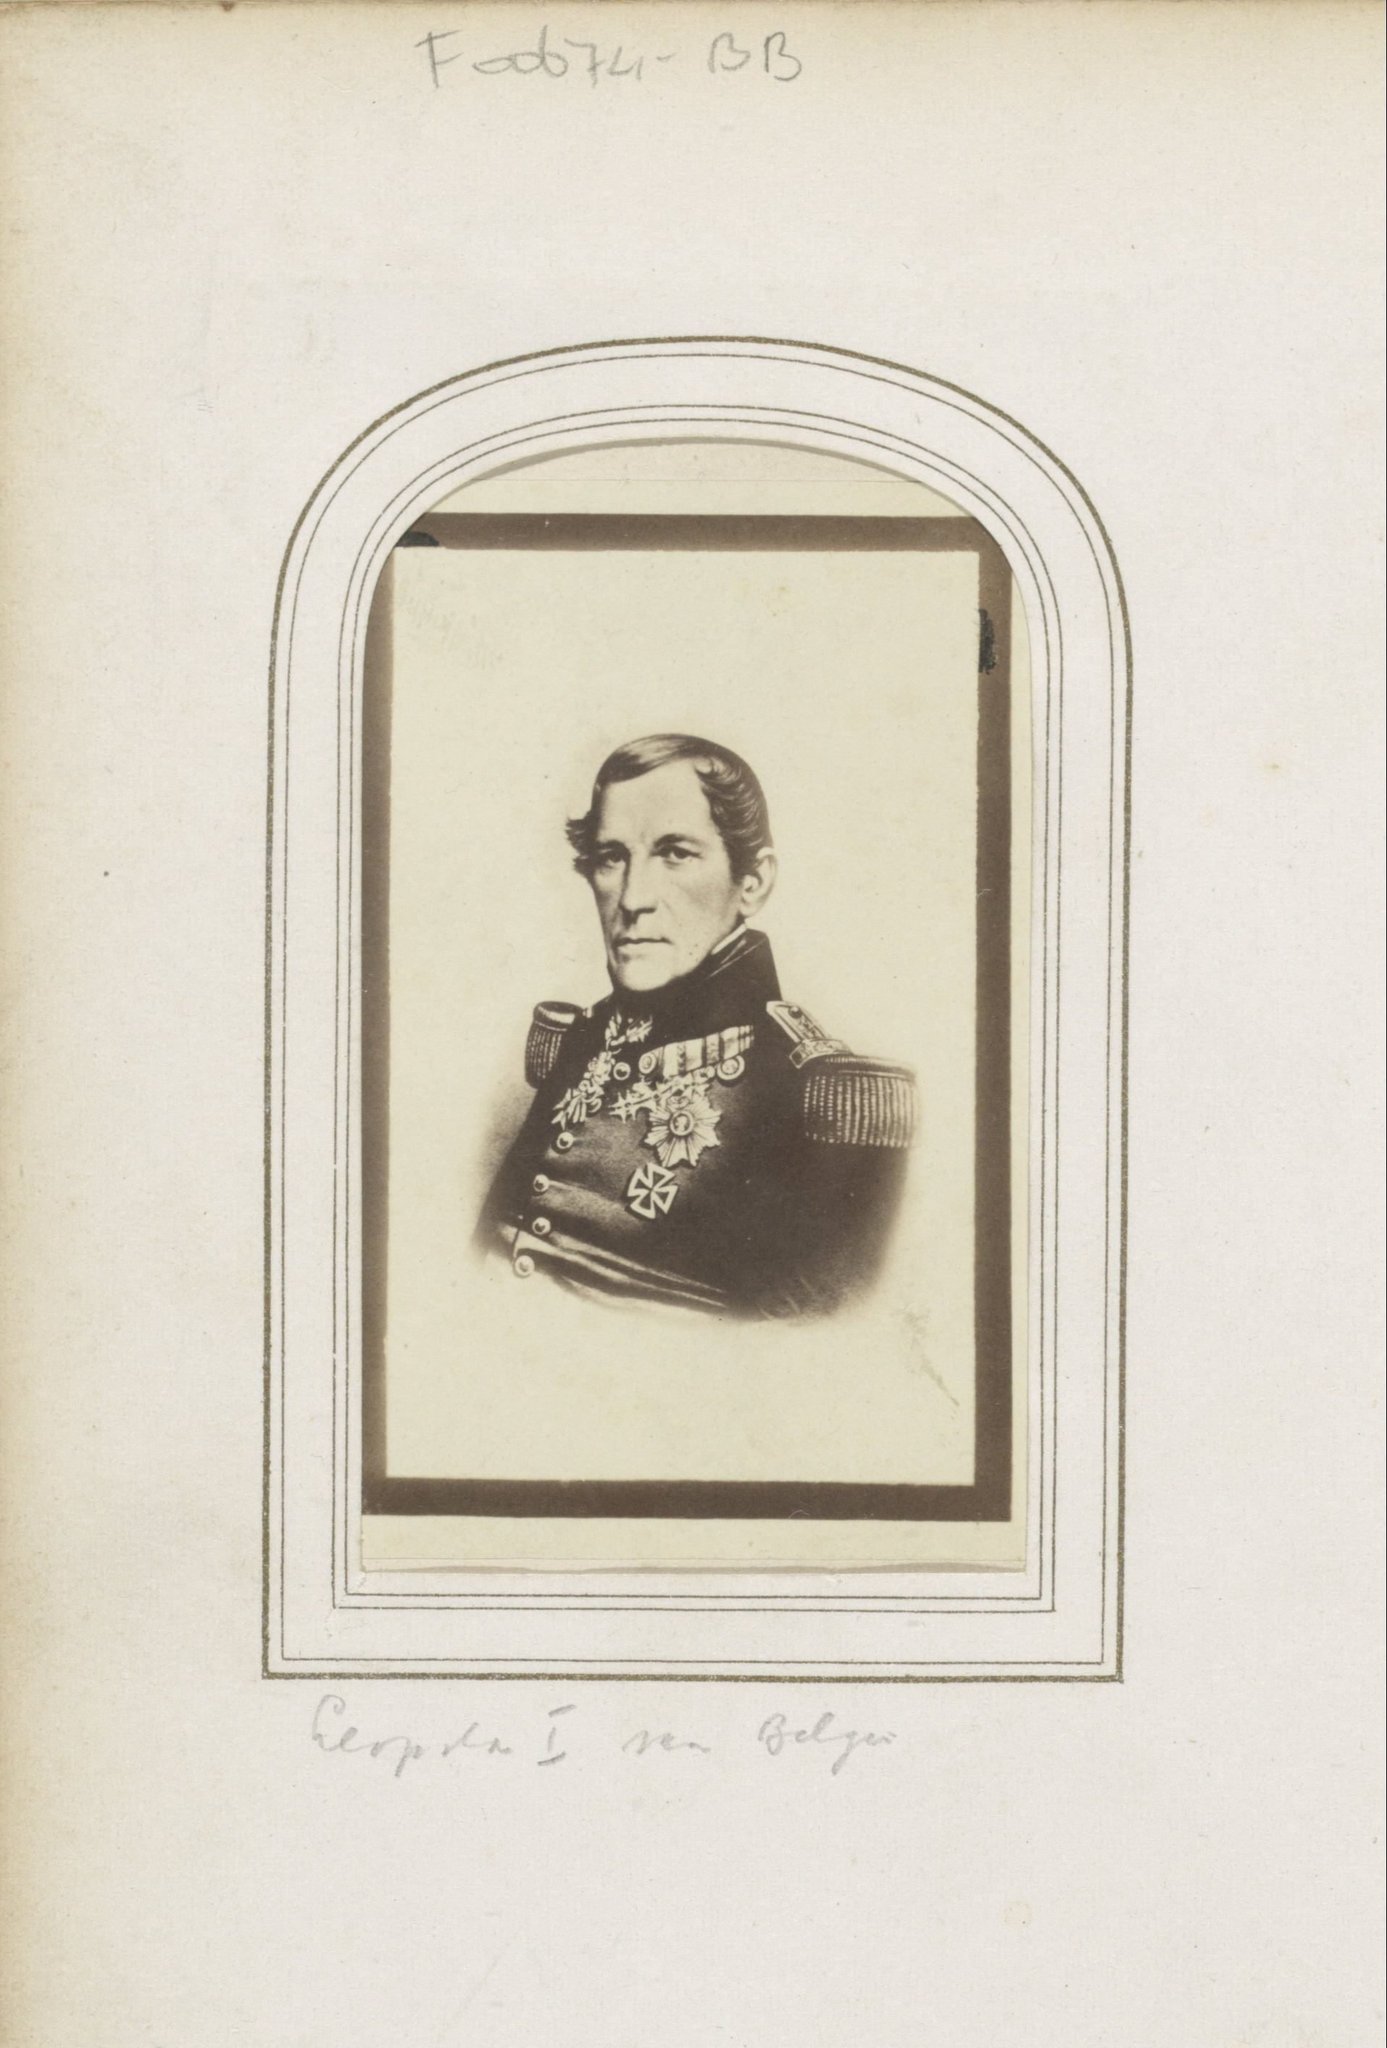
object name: carte de visite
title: Fotoreproductie van (vermoedelijk) een prent van koning Leopold I van Belgie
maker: Anonymous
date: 1855-1880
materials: cardboard, paper, photographic support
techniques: albumen print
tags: laeken, leopold i (koning der belgen), historical persons, medals and other marks of military honour, ruler, sovereign, hairdress, decorations, honours (as symbols of the state, etc.), (military) uniforms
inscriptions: inscription: ‘Léopold 1er.’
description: Onderdeel van Fotoalbum met 123 cartes-de-visite van leden van Europese vorstenhuizen, politici en bekende personen.